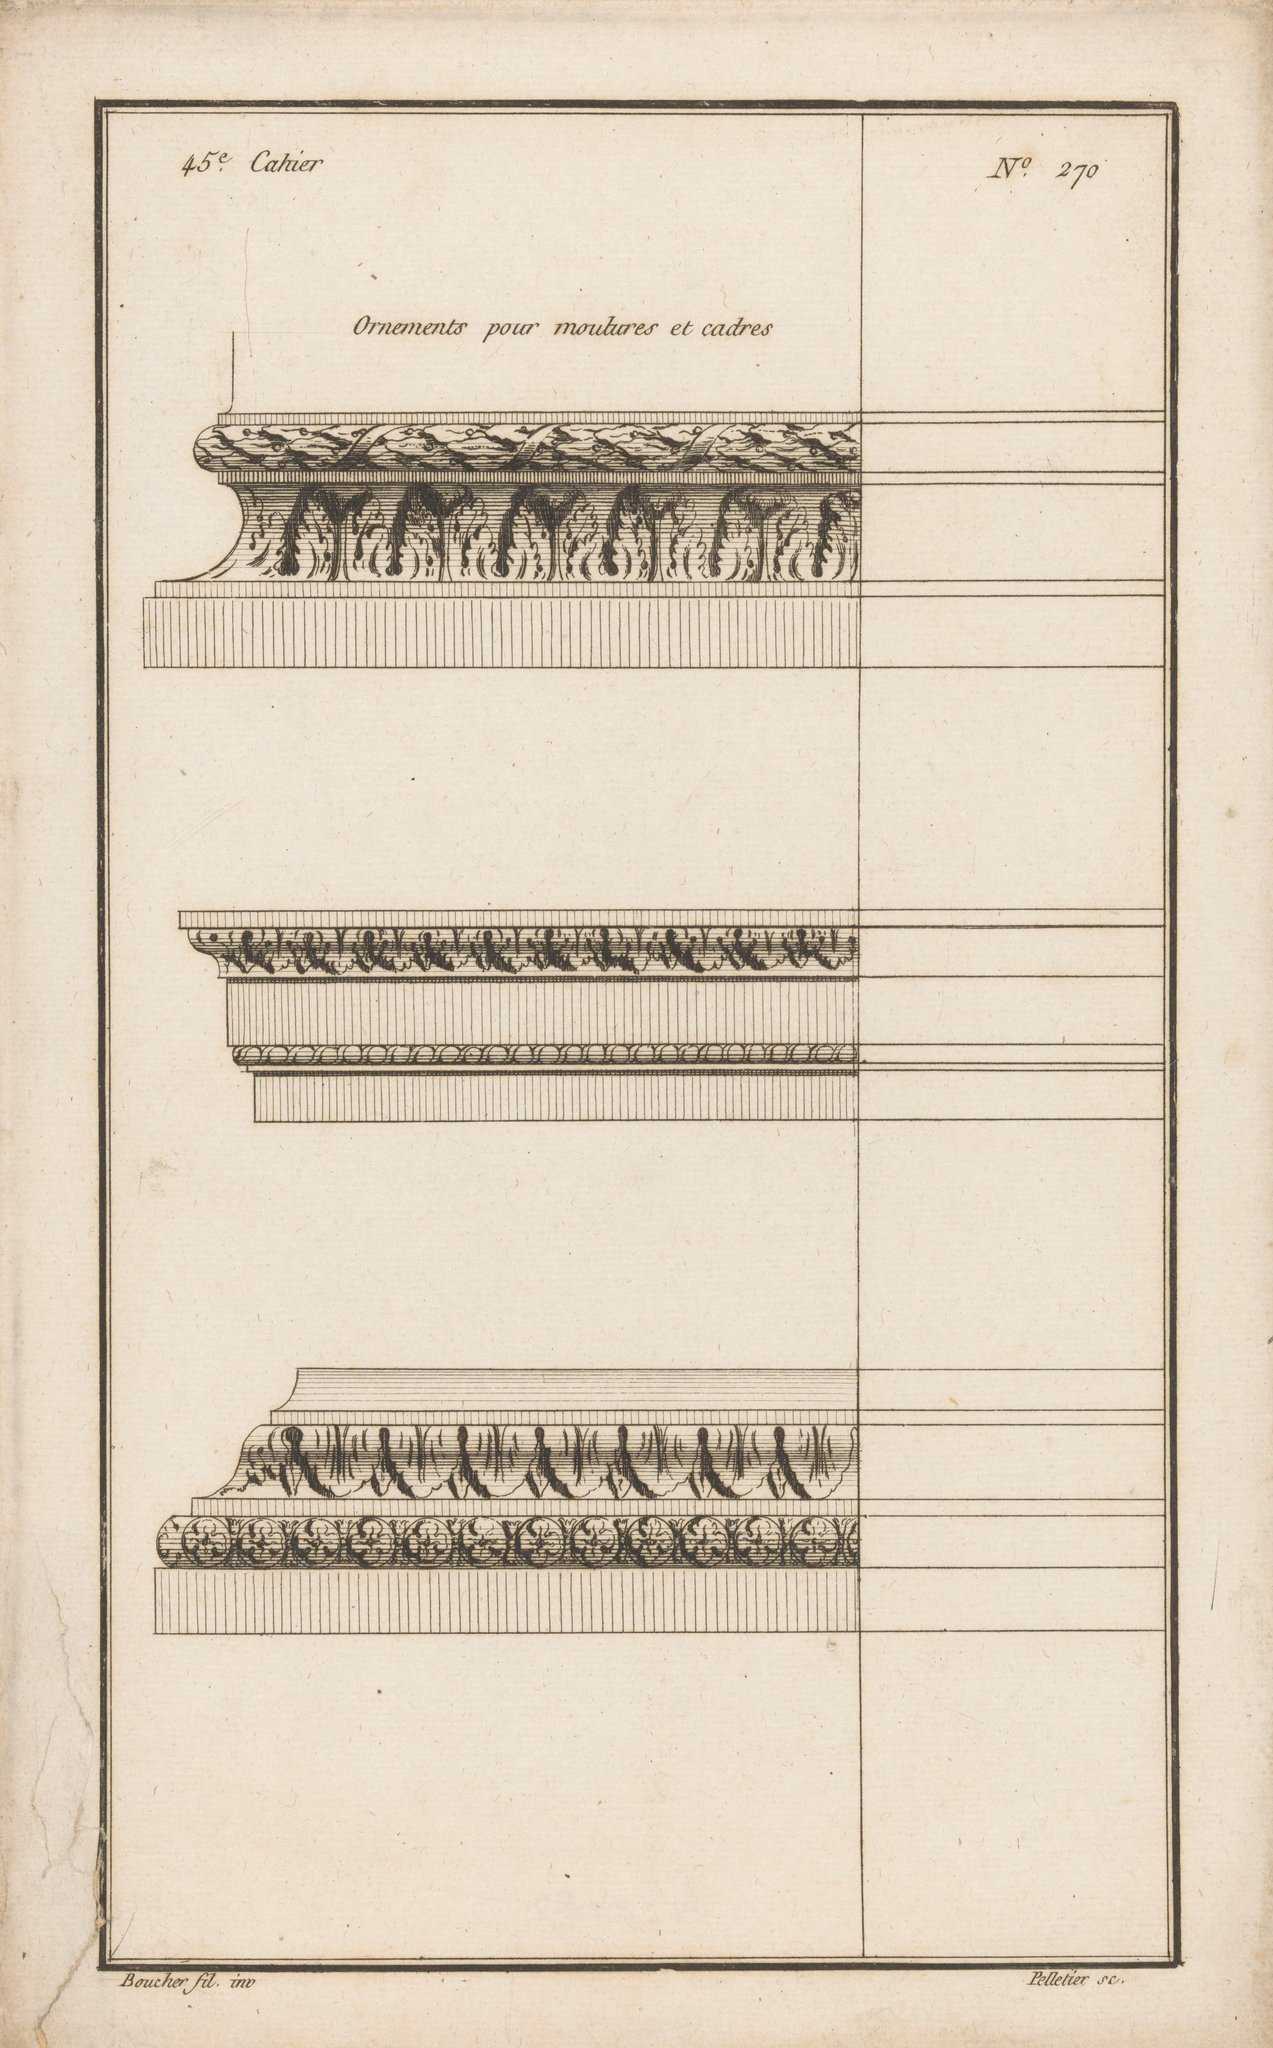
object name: print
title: 45e Cahier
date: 1772-1779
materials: paper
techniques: engraving, etching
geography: paris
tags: other architectural details (cornice), foliage ~ ornament, flowers ~ ornament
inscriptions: collector's mark: Lugt 2760, collector's mark: Lugt 2228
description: Drie lijsten geornamenteerd met blad- en bloemmotieven. Prentnummer 270.